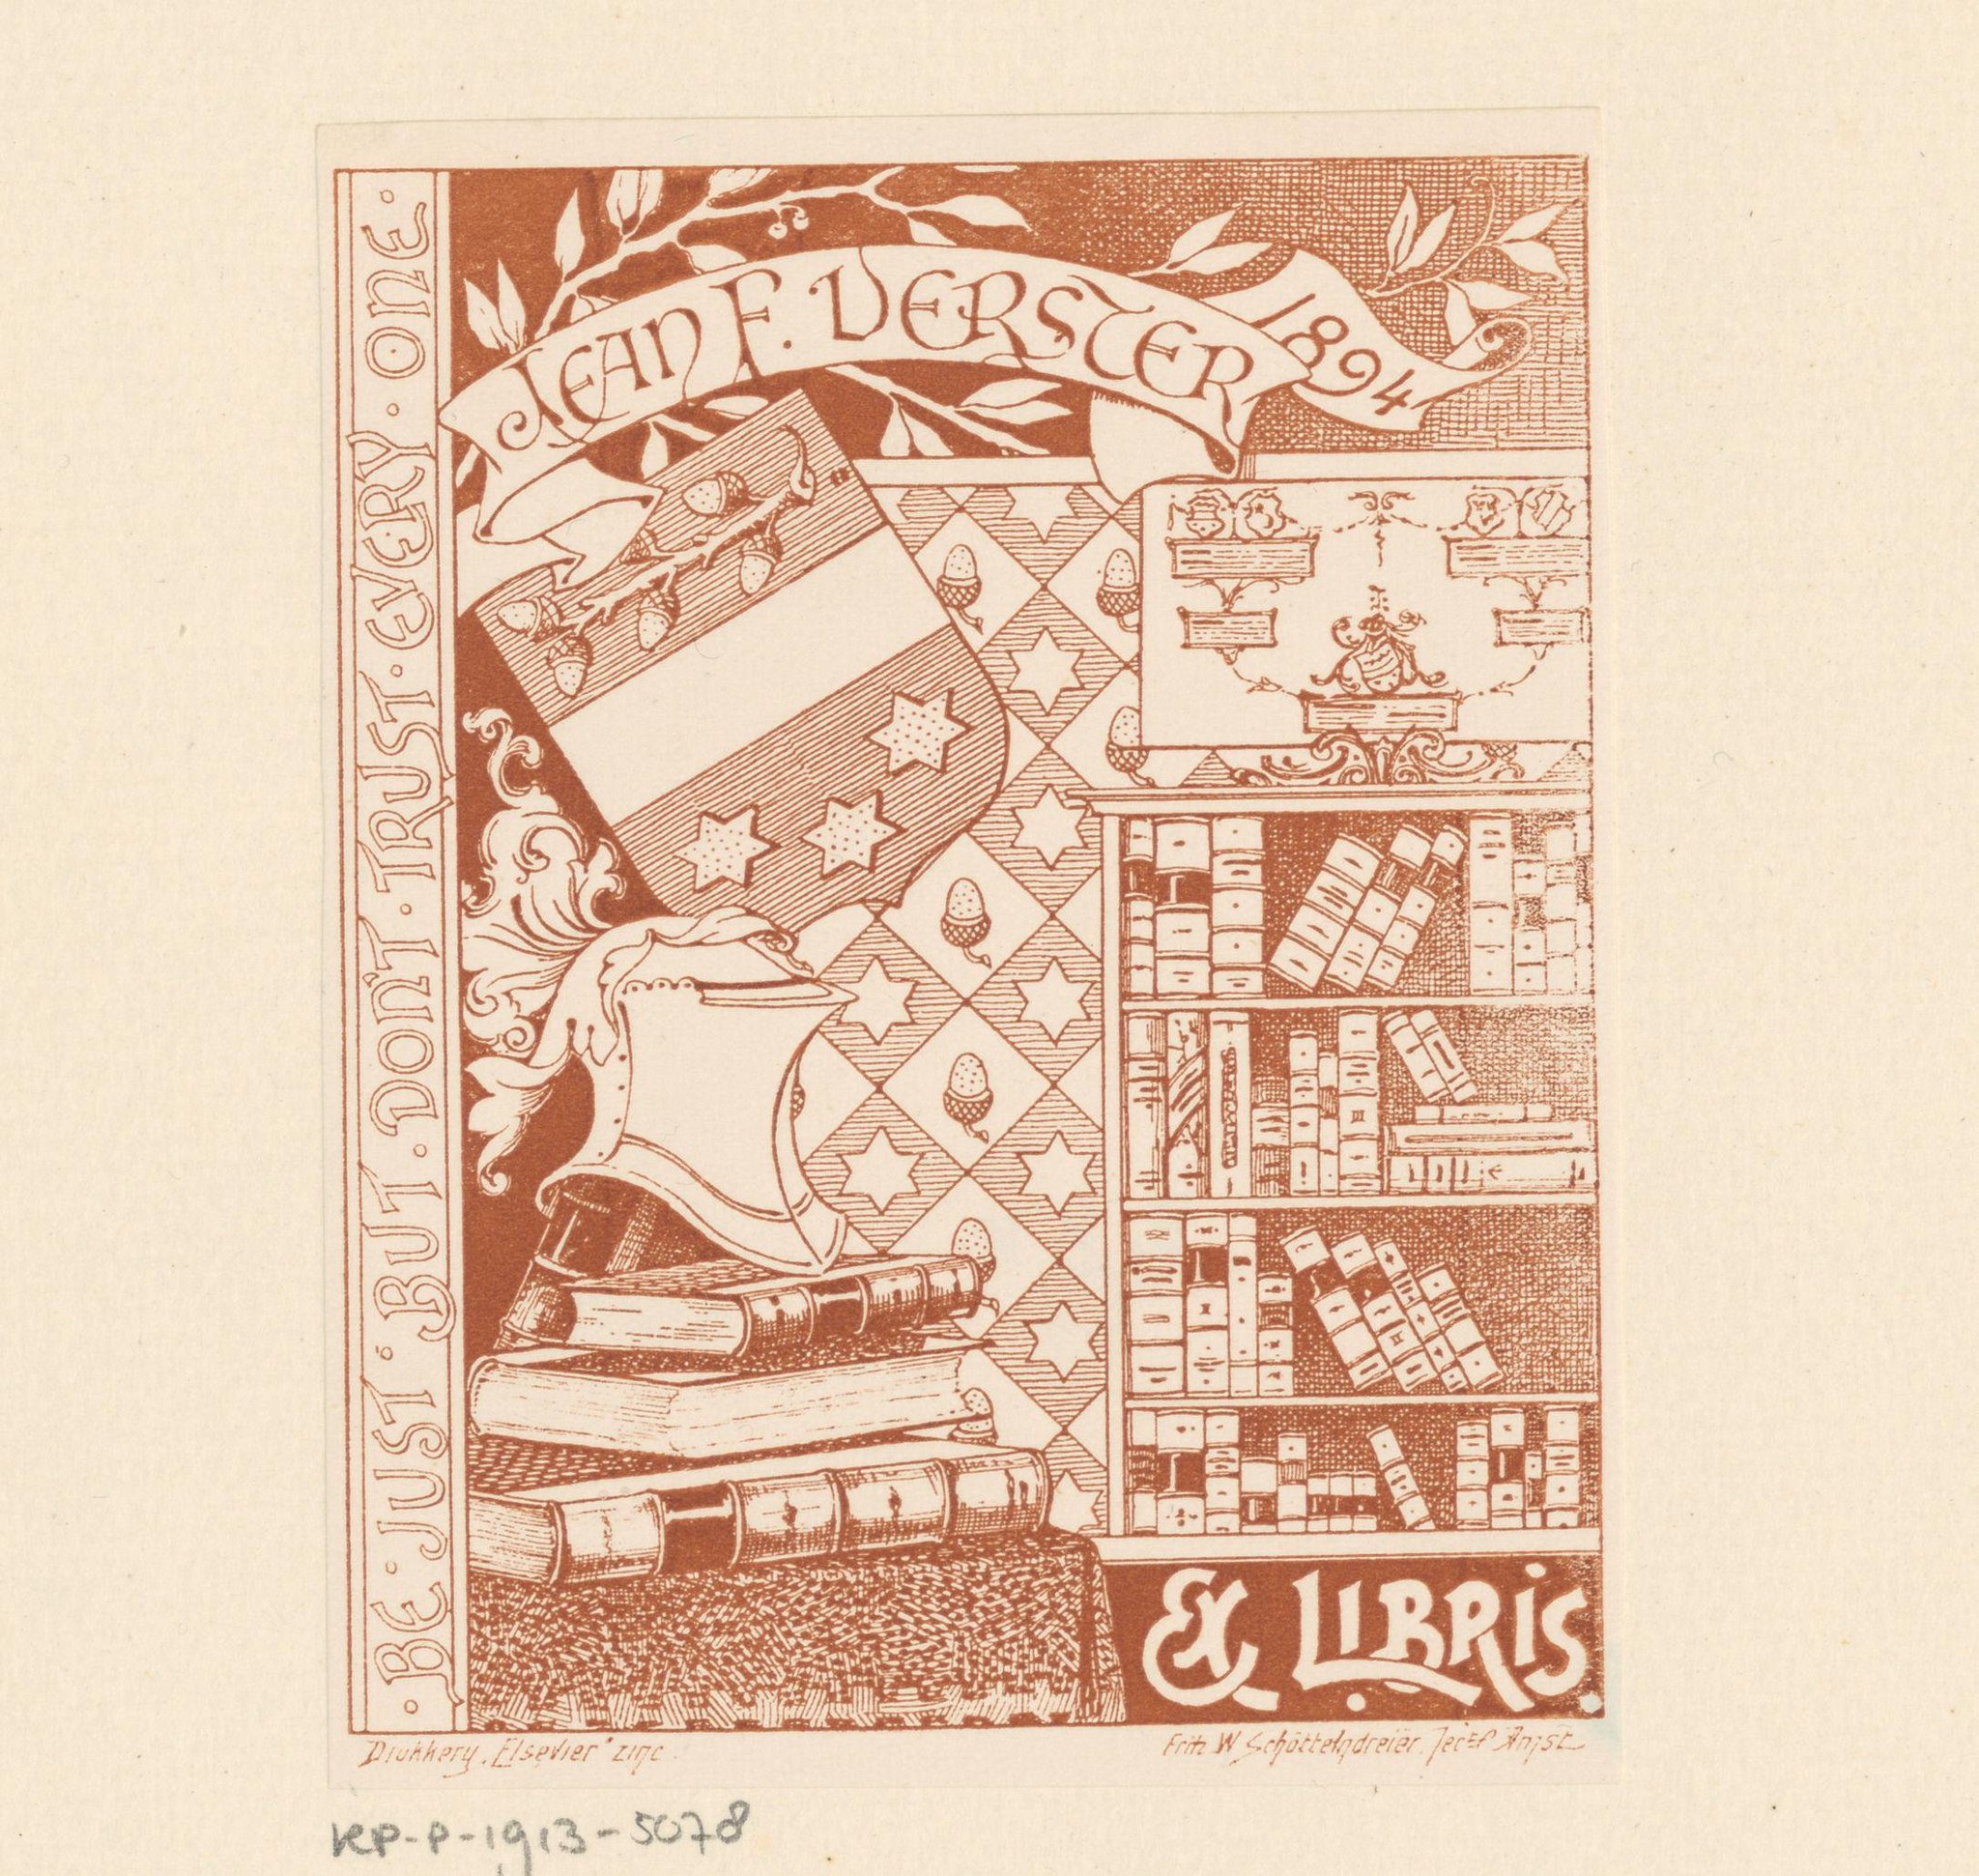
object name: bookplate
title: Ex libris van Jean F. Verster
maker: frederik willhelm schöttelndreier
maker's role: draughtsman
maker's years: 1868-1915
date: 1894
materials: paper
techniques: lithography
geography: netherlands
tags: bookshelves, book, armorial bearing, heraldry, fruits: acorn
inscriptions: collector's mark: Lugt 2233, collector's mark: Lugt 2760